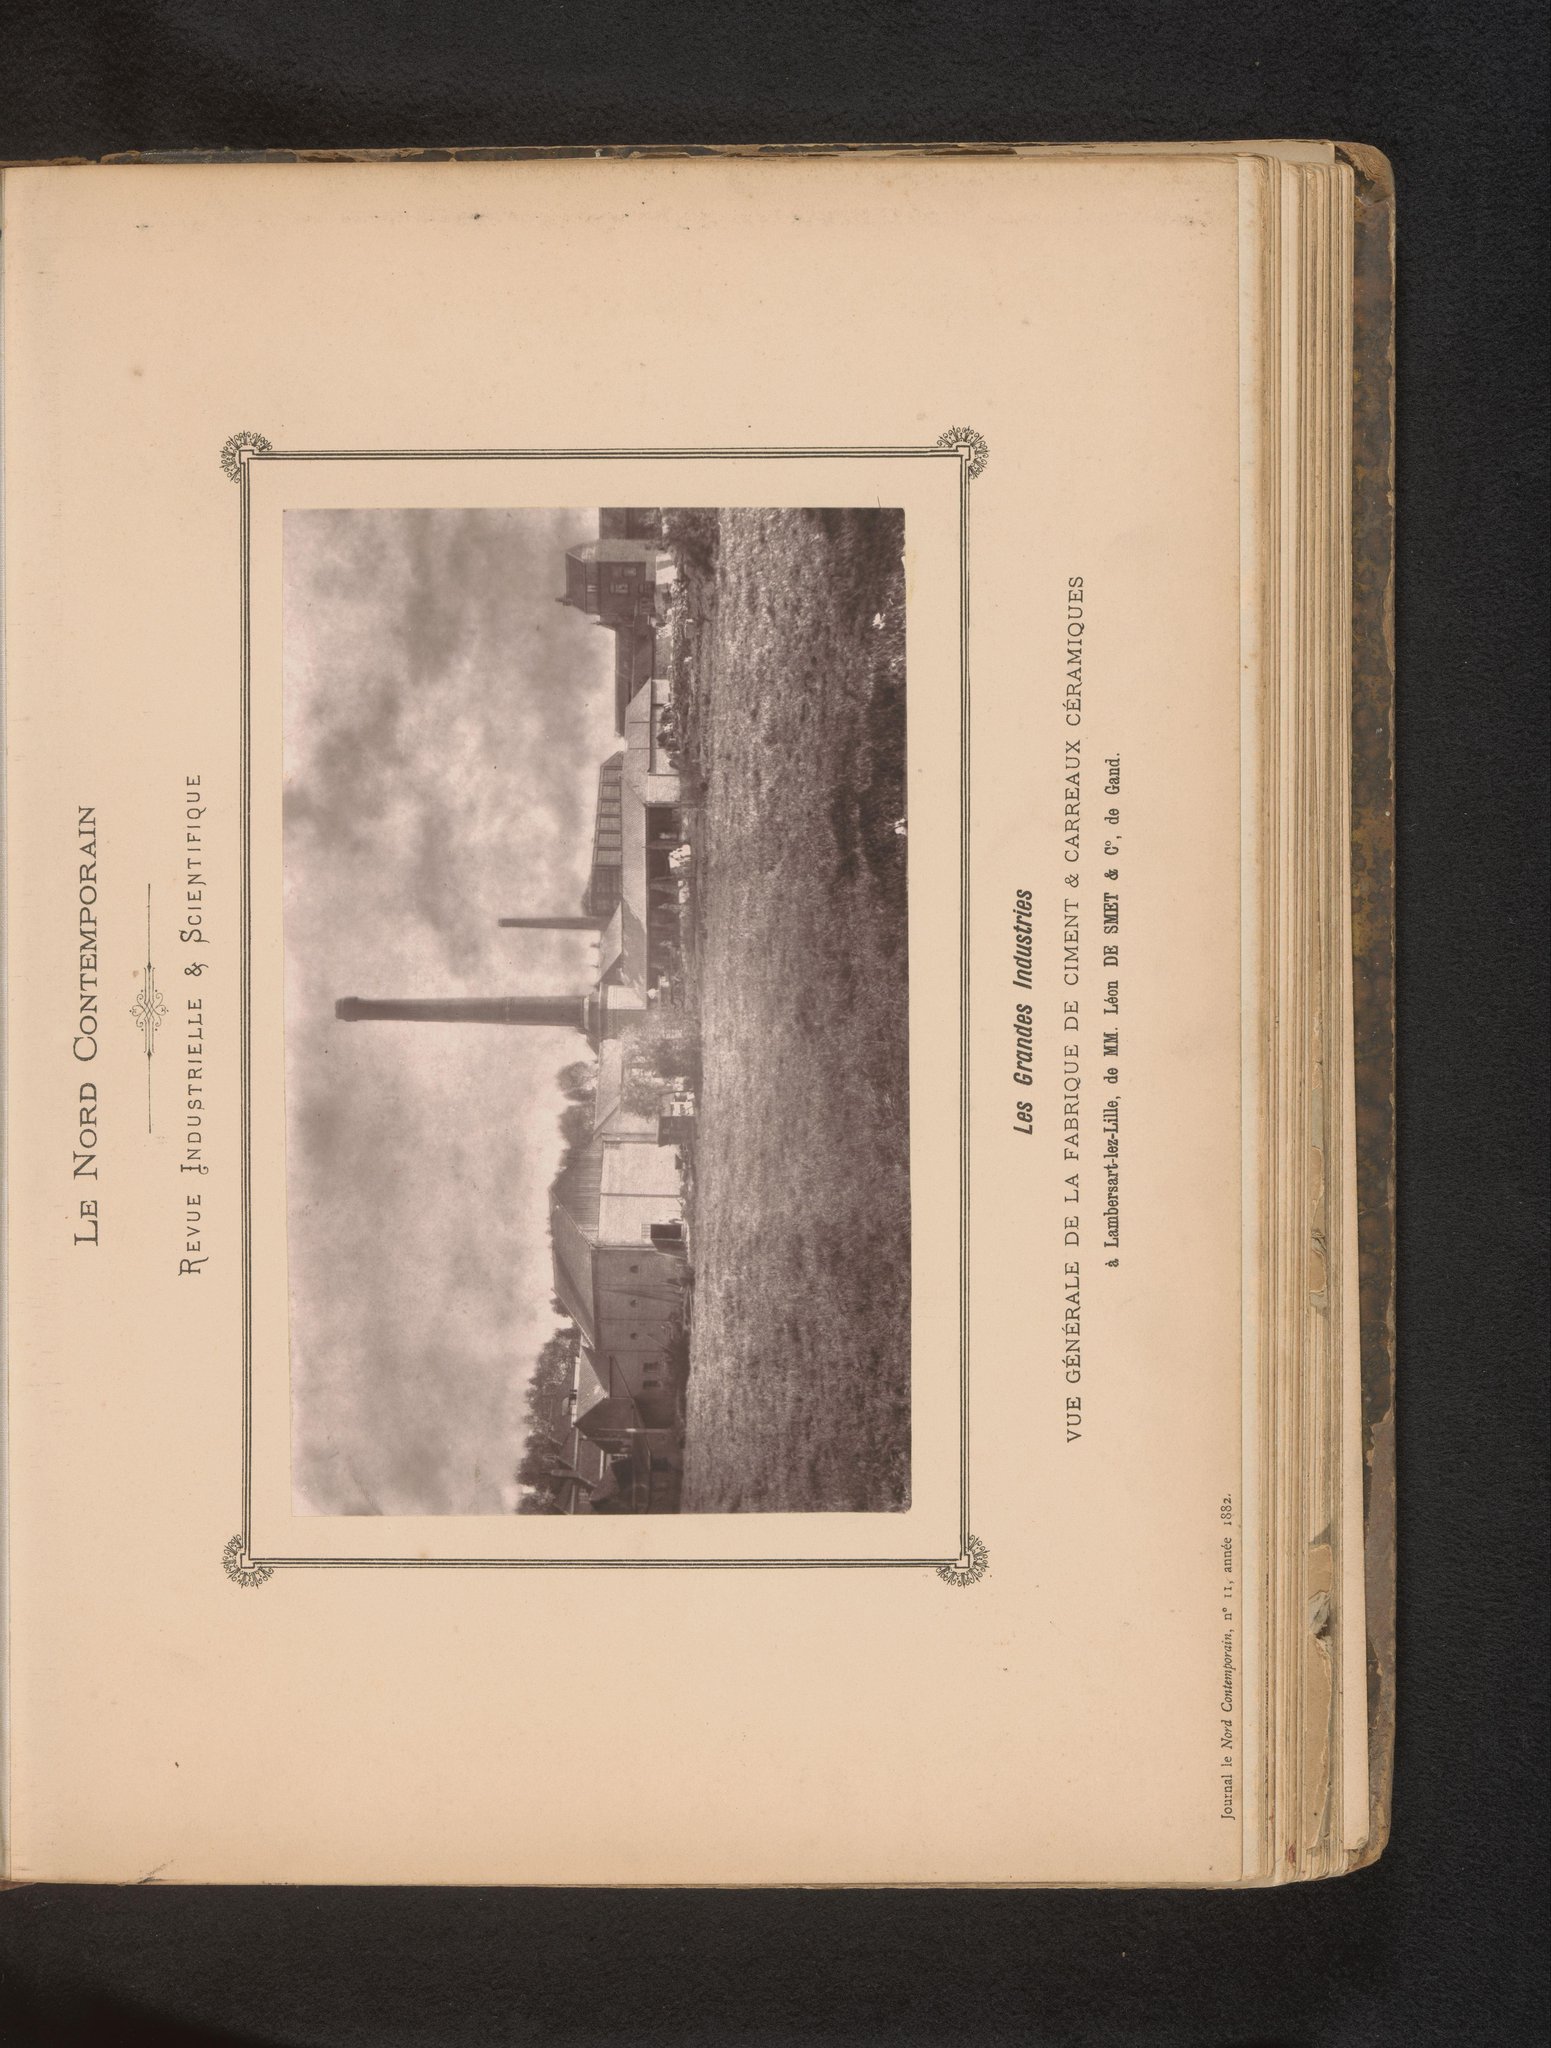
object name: page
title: Gezicht op de cementfabriek te Lille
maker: Anonymous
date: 1878-1882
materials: paper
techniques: woodburytype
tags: factory in landscape, lille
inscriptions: inscription: ‘Le Nord Contemporain/ Revue Industrielle & Scientifique’, inscription: ‘Vue générale de la fabriqu de ciment & carreaux céramiques á Lambersart-lez-Lille, de M. Léon de Smet & Co, de Grand.’, inscription: ‘Journal le Nord Contemporain, No 11, année 1882’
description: Prent op vijfde ongenummerde pagina na pagina 176.